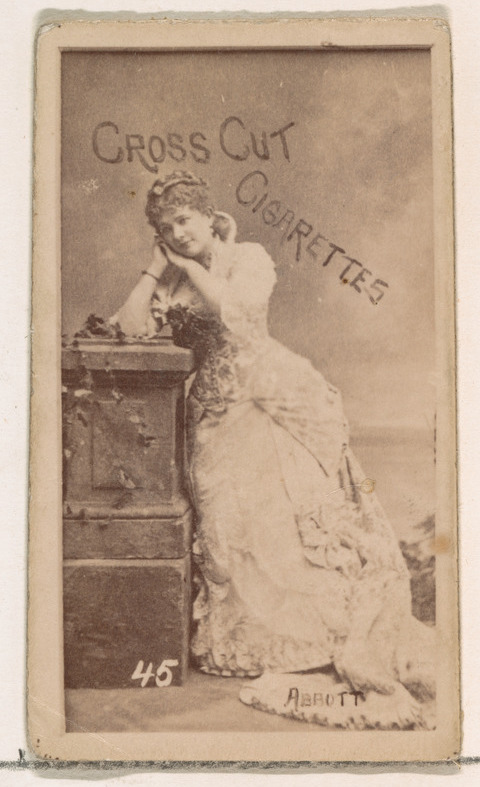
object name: print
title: Card Number 45, Abbott, from the Actors and Actresses series (N145-1) issued by Duke Sons & Co. to promote Cross Cut Cigarettes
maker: w. duke, sons & co.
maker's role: publisher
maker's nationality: american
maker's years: 1870-1920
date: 1880-1889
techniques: albumen silver print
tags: portraits,women,actresses